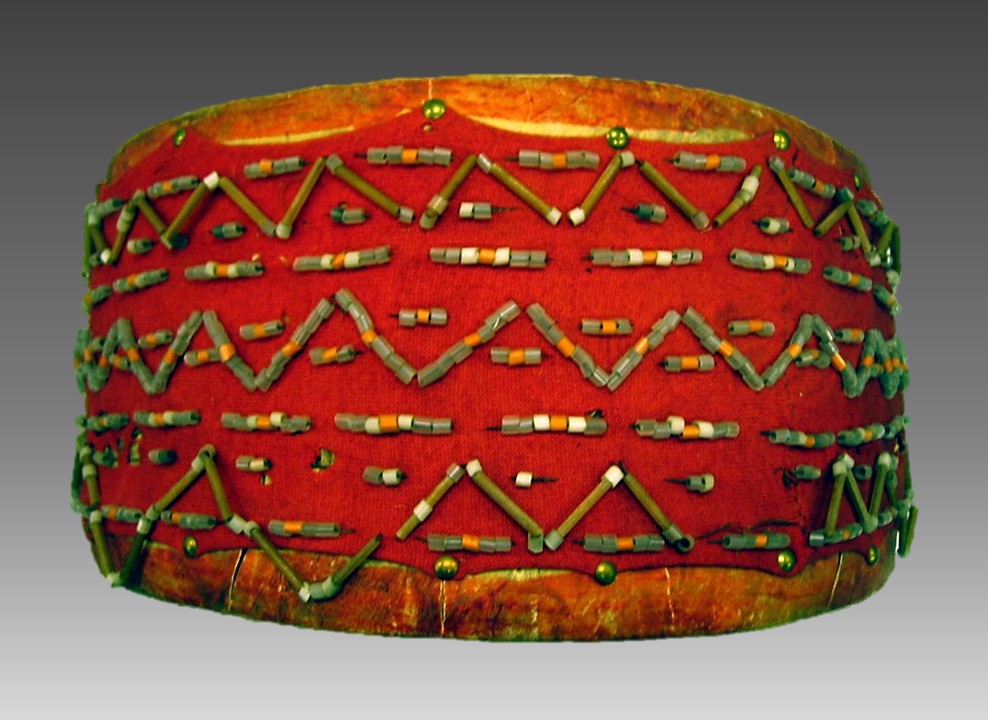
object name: drum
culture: native american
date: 1801-1900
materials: skin, wood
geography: united states